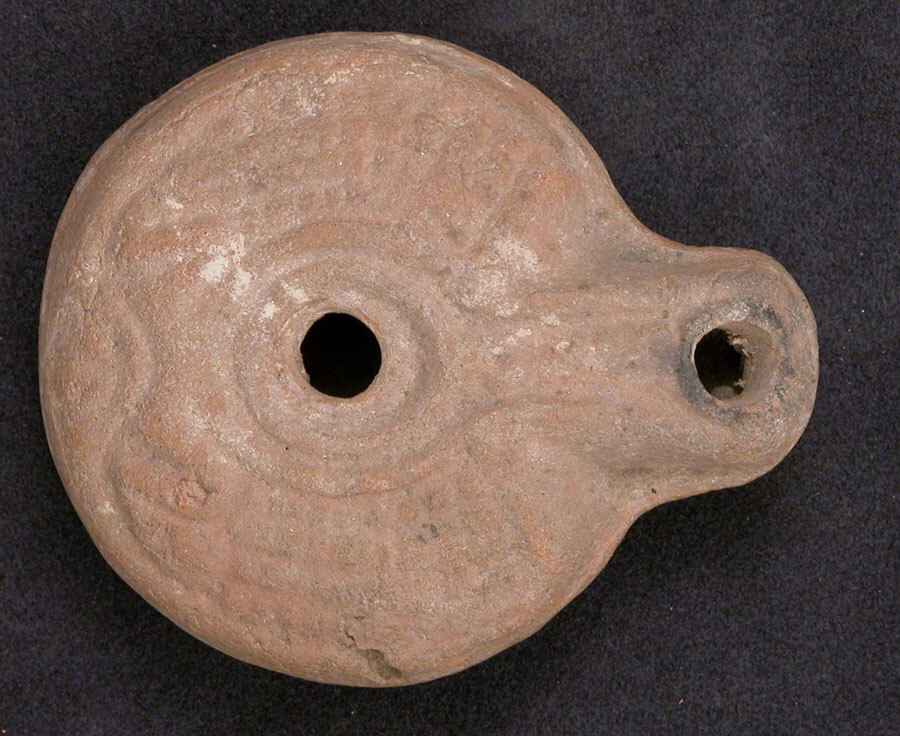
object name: lamp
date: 201-700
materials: earthenware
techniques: molding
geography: egypt